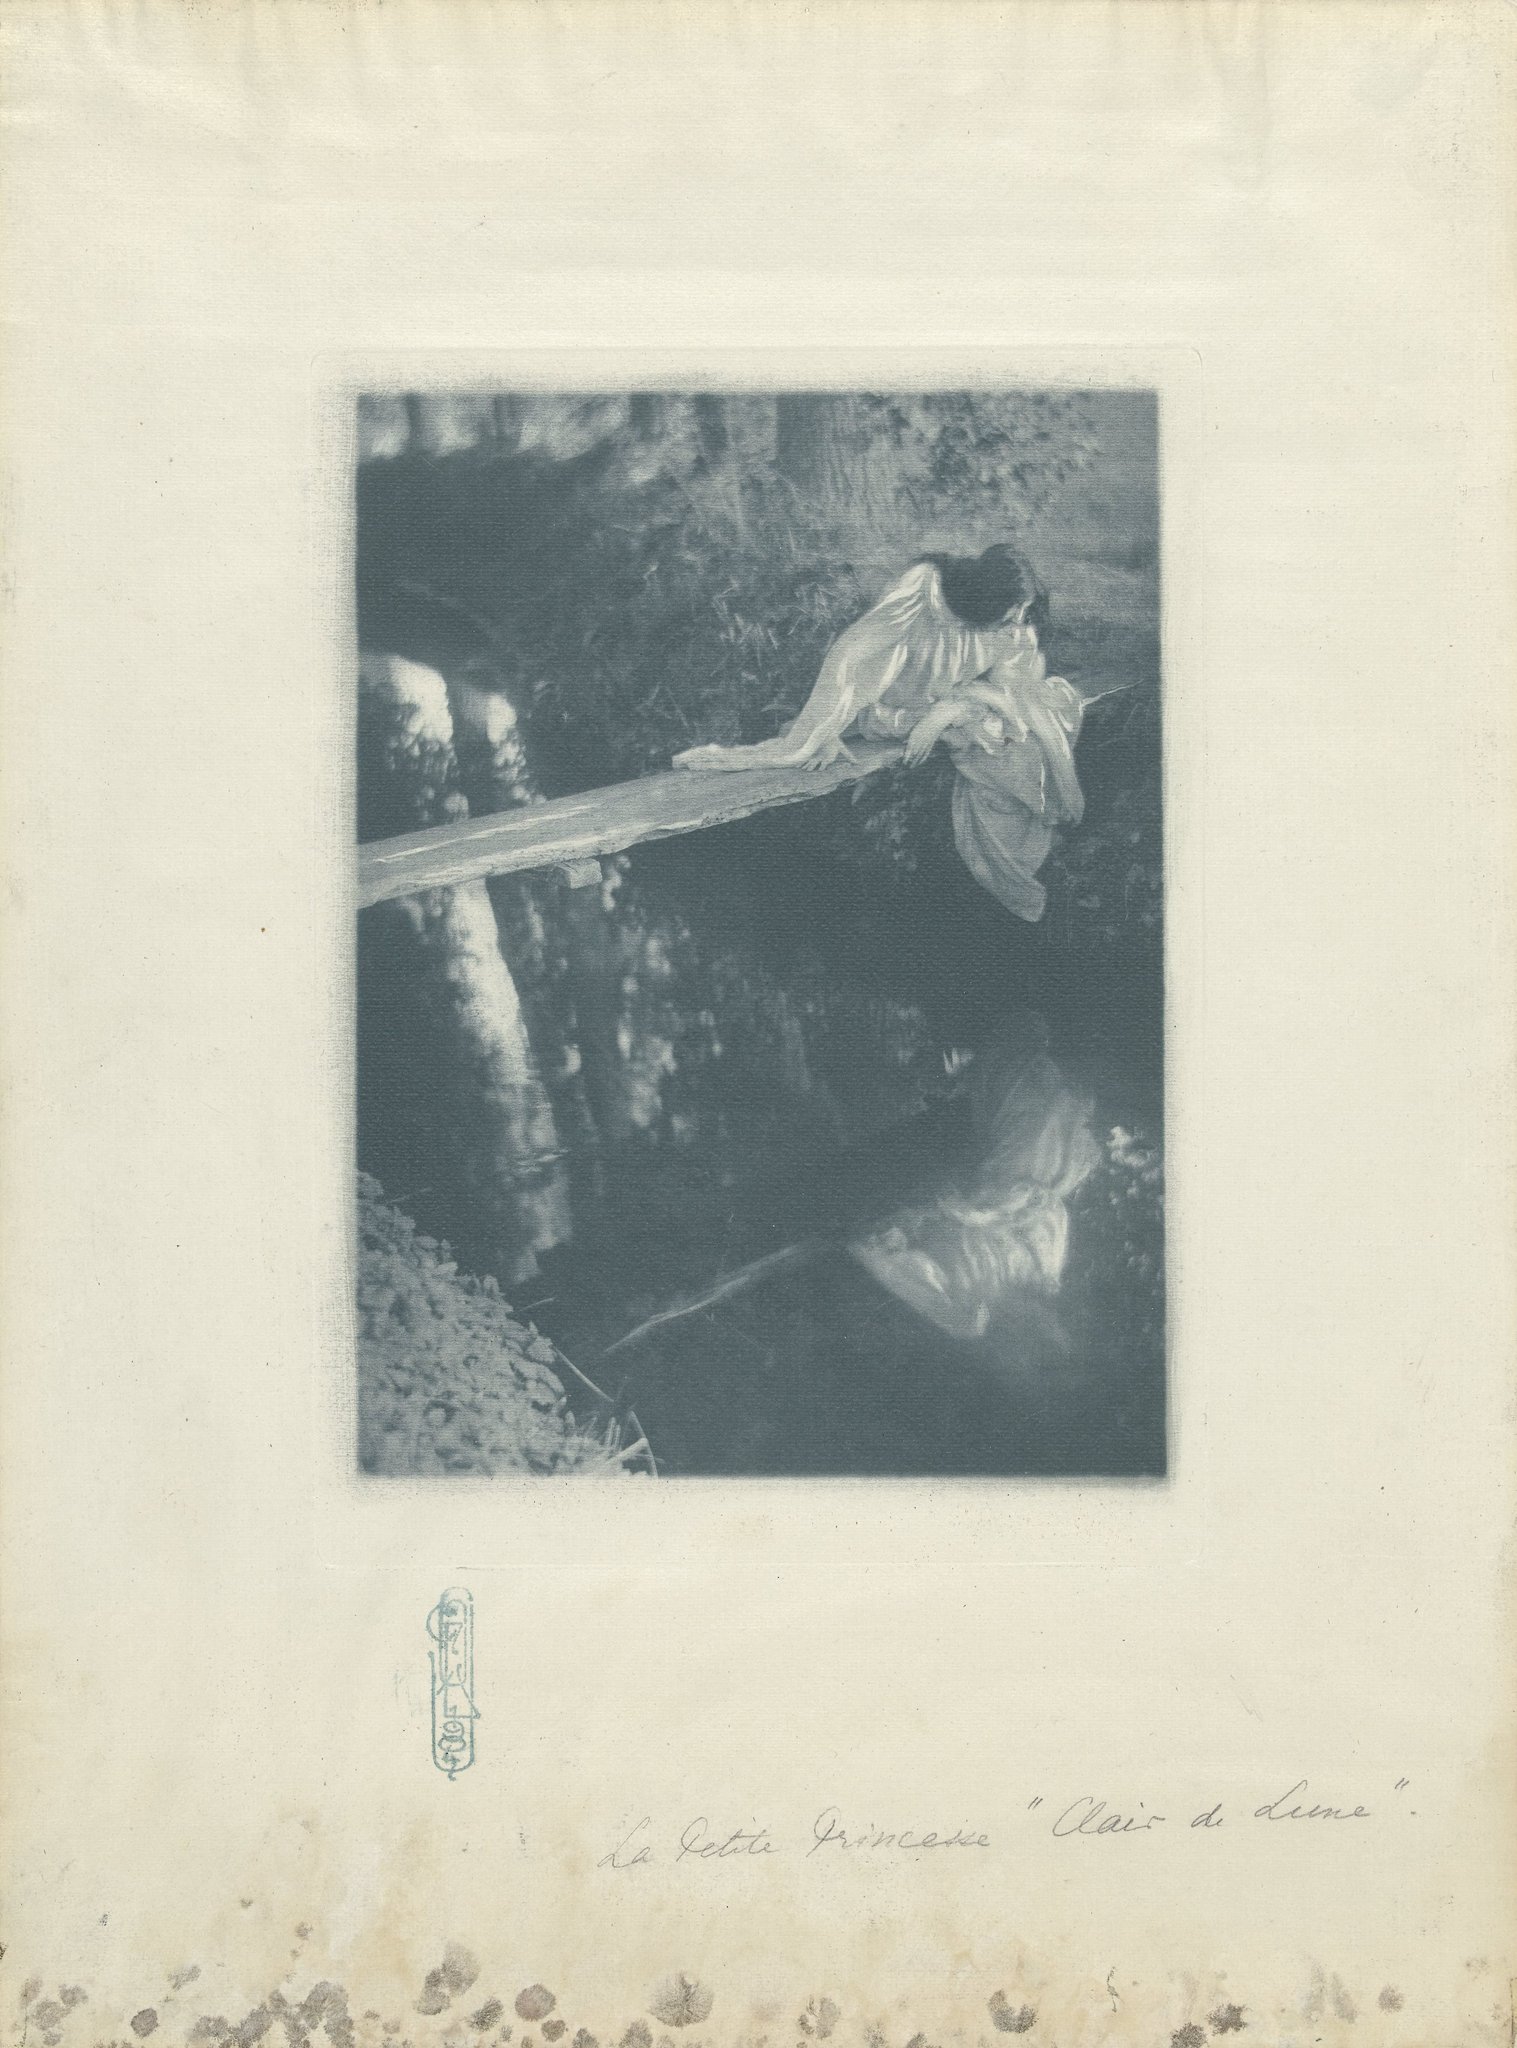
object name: photograph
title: Vrouw zit op een boomstam boven het water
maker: constant puyo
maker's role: fotograaf, schrijver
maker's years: 1857-1933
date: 1890-1910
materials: cardboard, paper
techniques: gum bichromate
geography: france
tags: france